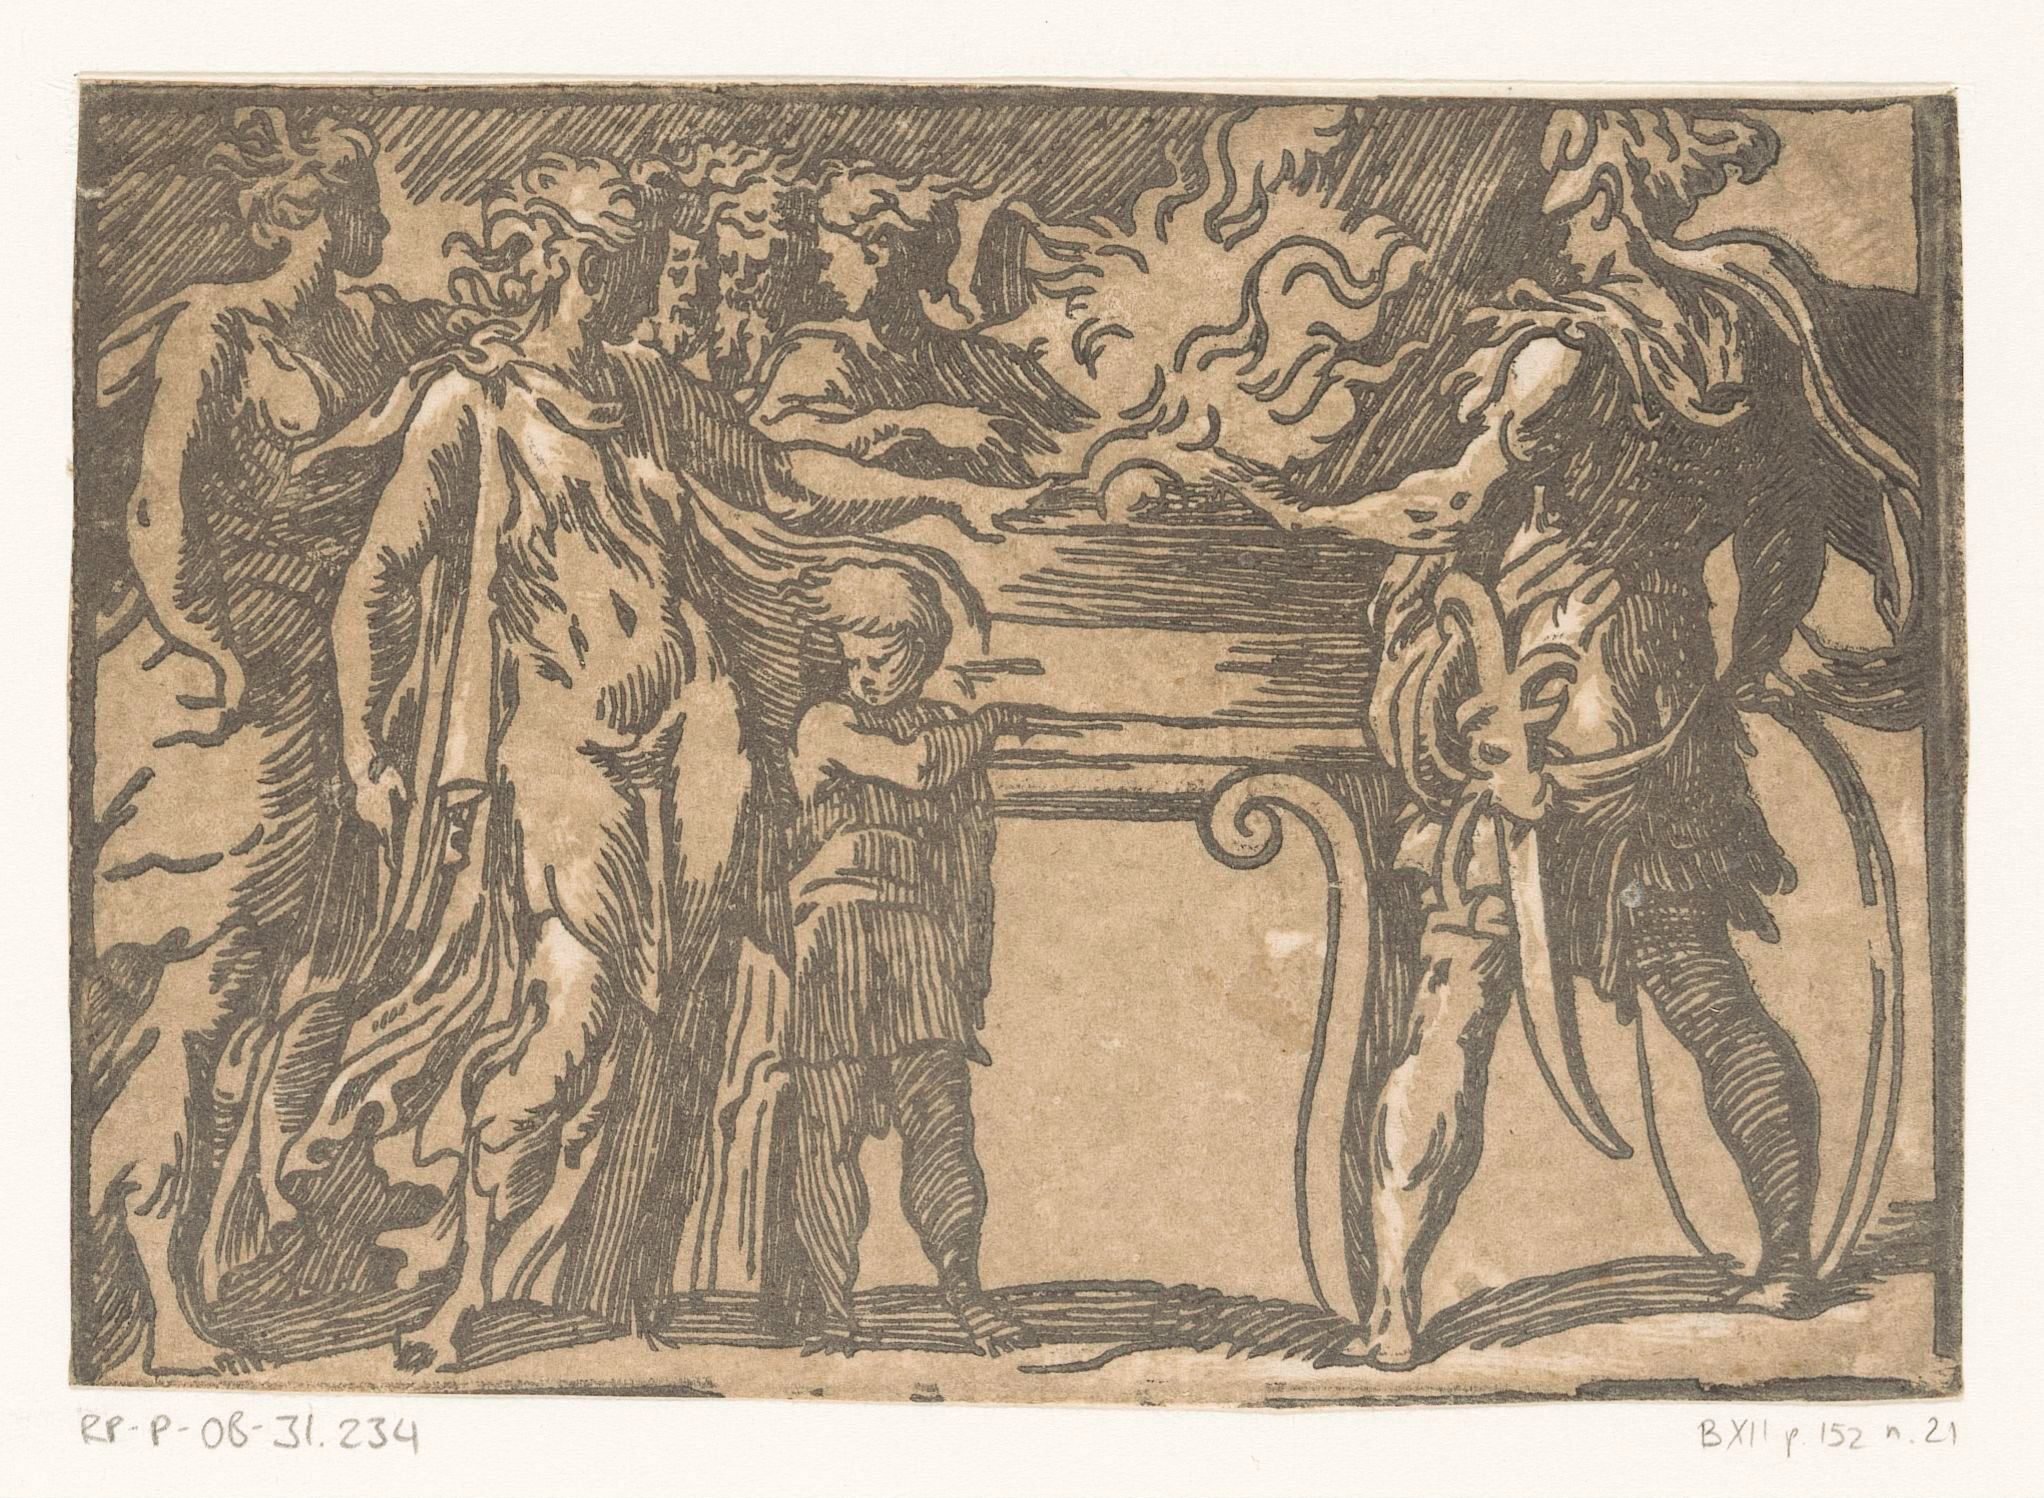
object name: print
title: Mucius Scaevola steekt zijn hand in het vuur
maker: antonio da trento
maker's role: painter, print maker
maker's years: 1510-1550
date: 1520-1550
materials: paper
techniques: woodcut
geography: italy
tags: gaius mucius scaevola before porsena: he thrusts his right hand into the flames (the body of the king's secretary who erroneously had been killed instead of porsena may be seen lying on the ground)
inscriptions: collector's mark: Lugt 240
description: De Romein Mucius Scaevola steekt zijn hand in een altaar vuur om zijn zelfbeheersing te tonen aan Lars Porsenna, de koning van Clusium.